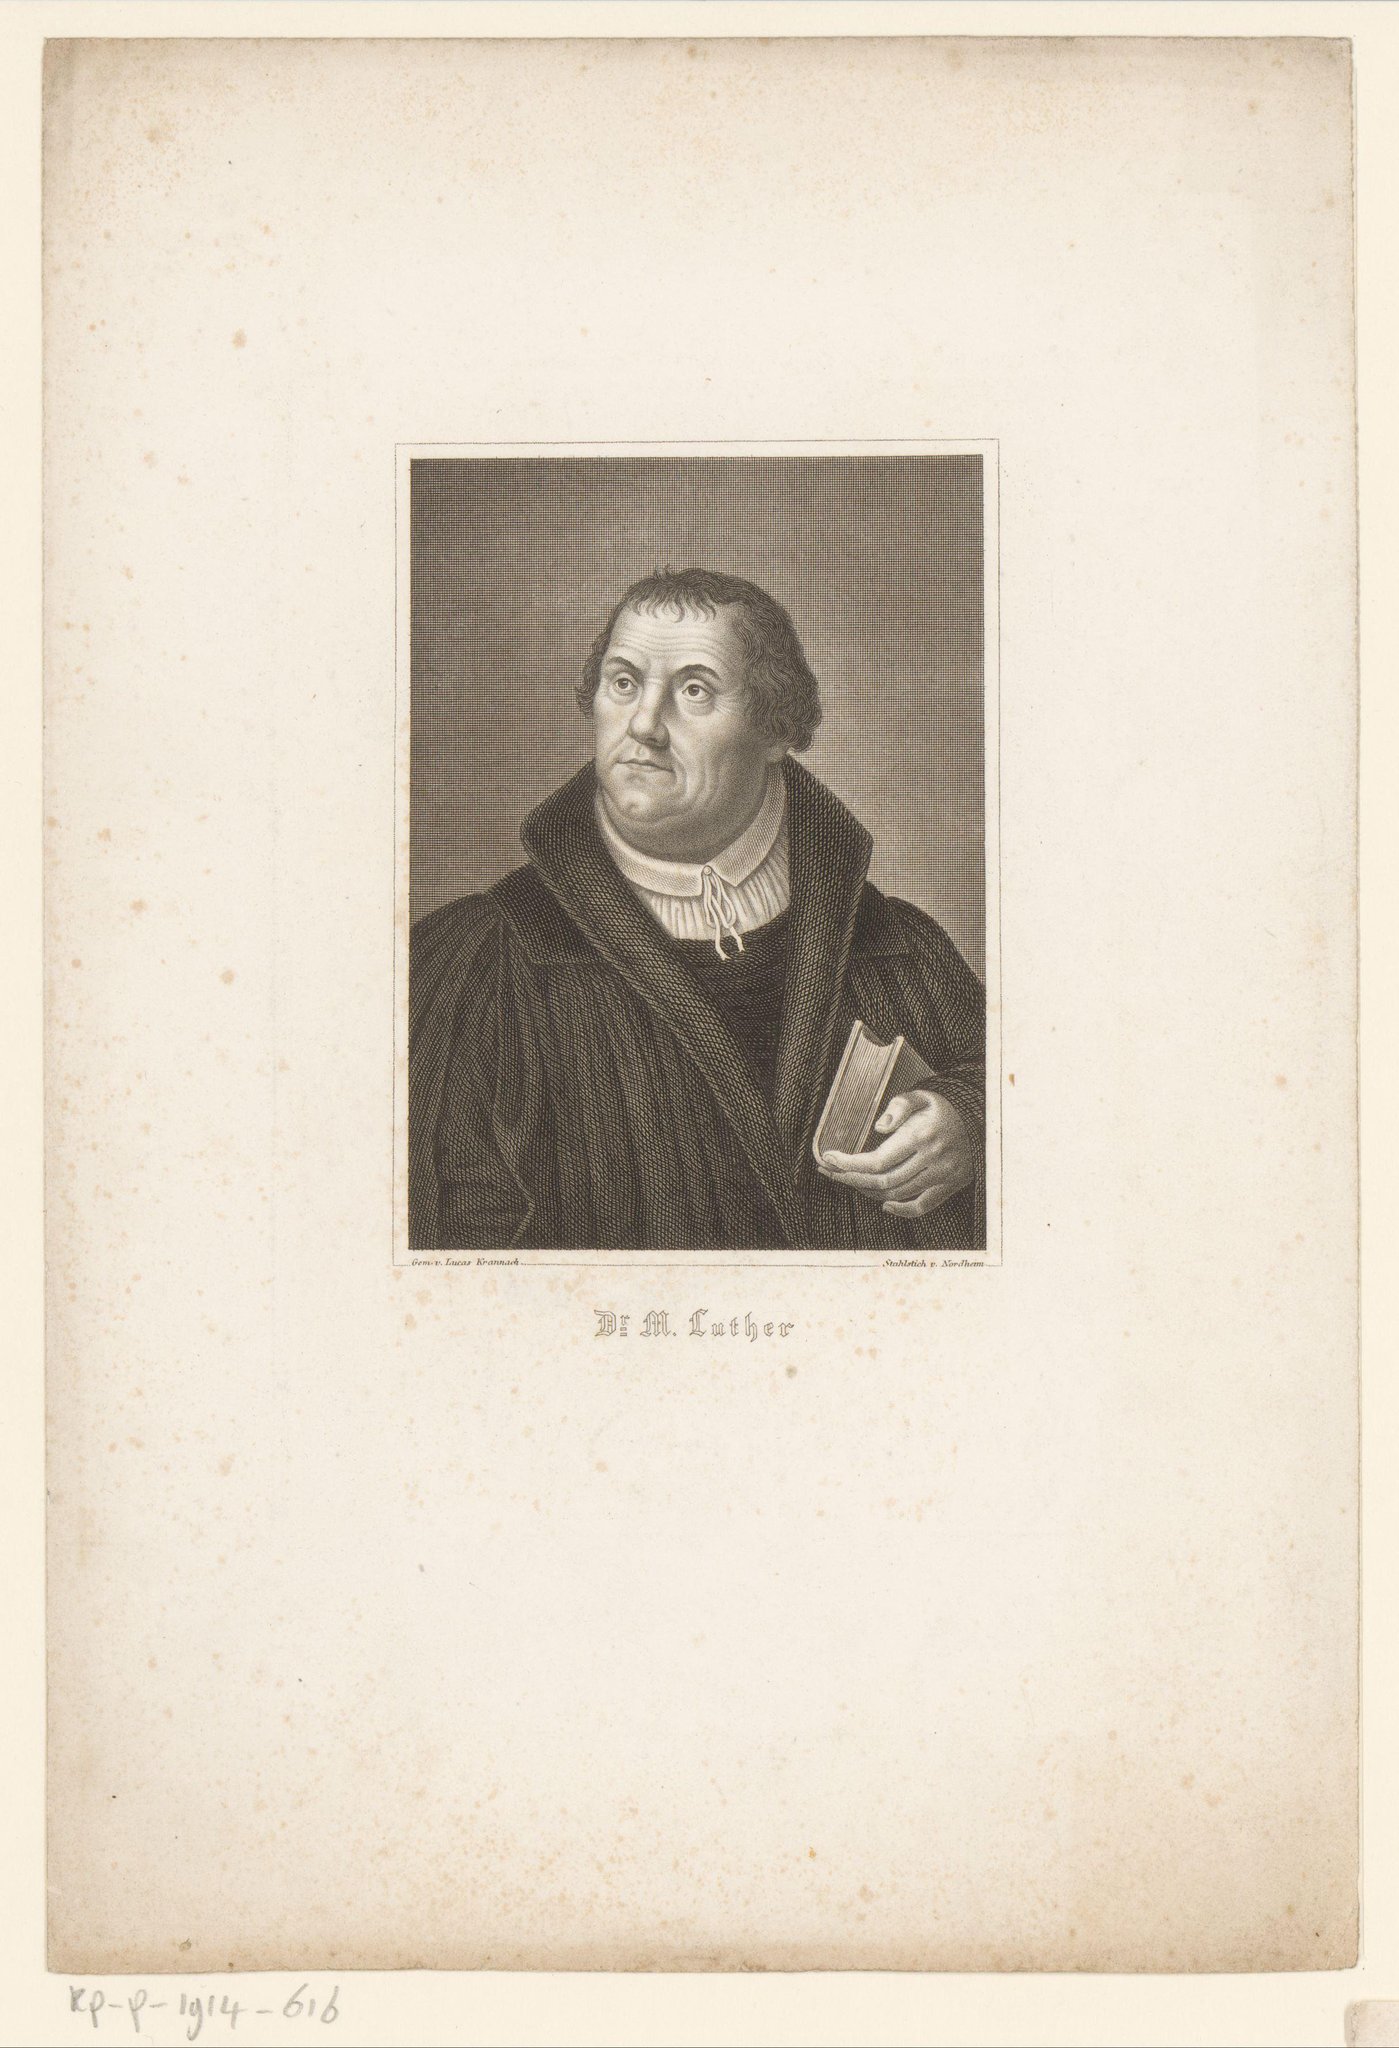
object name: print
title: Portret van Martin Luther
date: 1814-1853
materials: paper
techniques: engraving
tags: priest, martin luther, theologian, historical persons, book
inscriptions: collector's mark: Lugt 2228